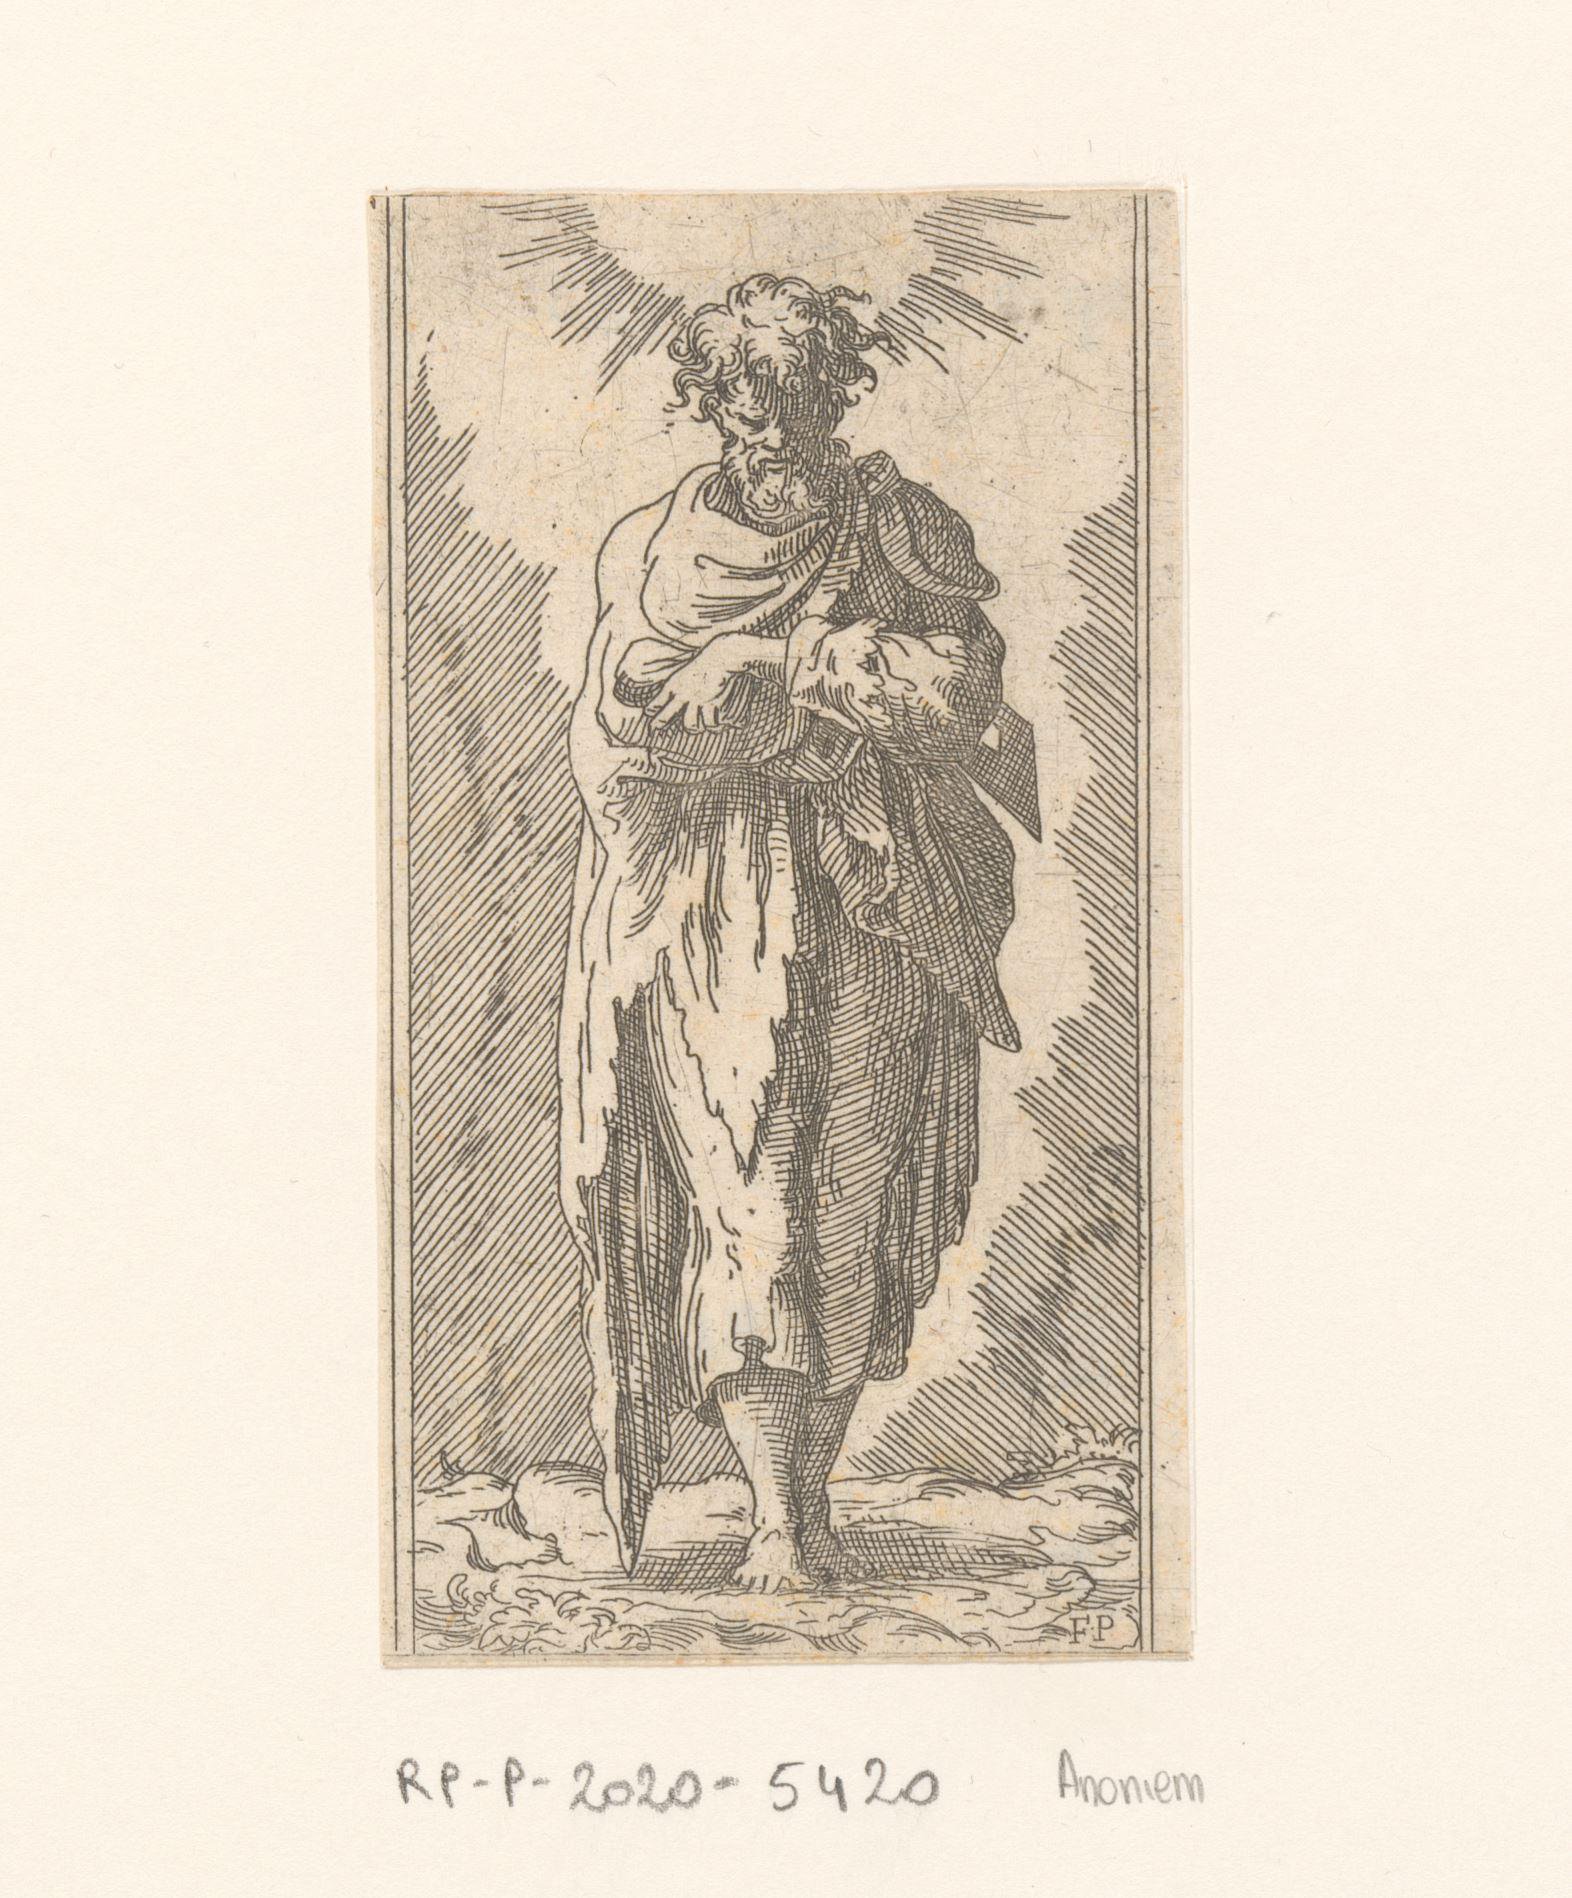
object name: print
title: Heilige Judas Taddeüs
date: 1520-1600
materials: paper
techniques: etching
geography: italy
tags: the apostle jude thaddaeus; possible attributes: book, club, halberd, scroll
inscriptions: collector's mark: Lugt 2166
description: Spiegelbeeldige kopie naar RP-P-H-D-41. Monogrammist FP ontleende het ontwerp weer aan Schiavone, Antonio da Trento of direct aan Parmigianino.